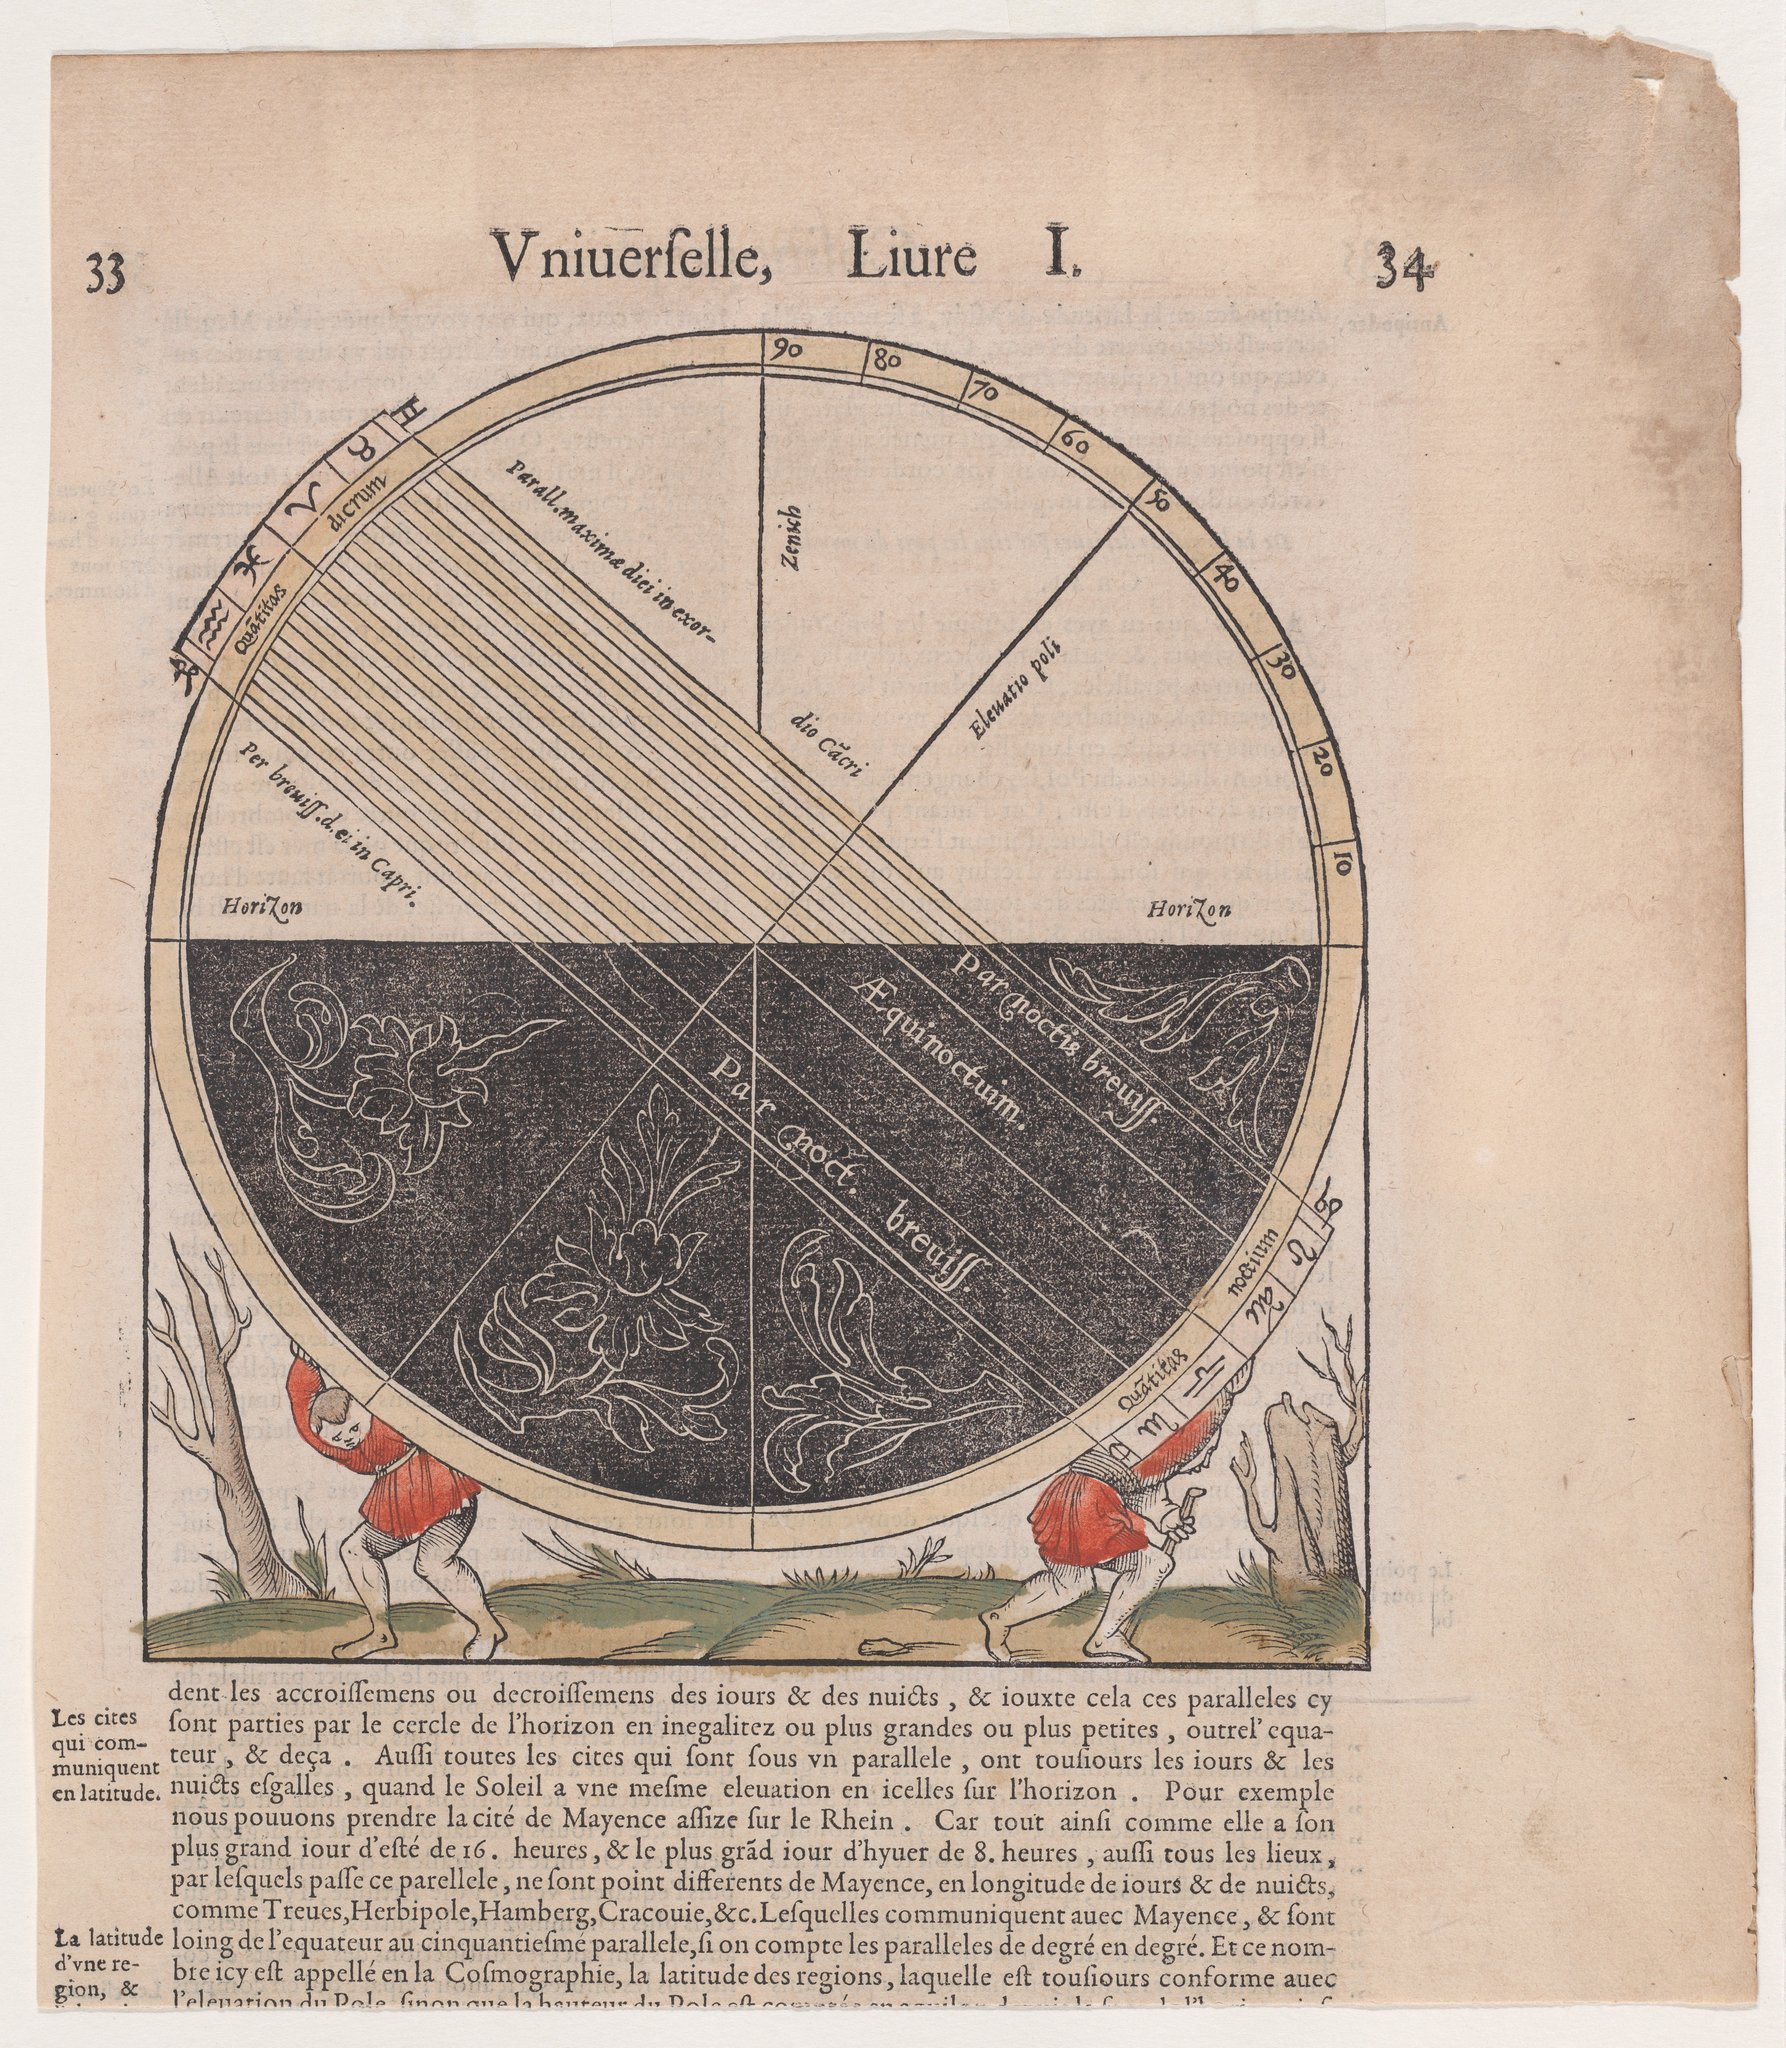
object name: print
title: Page from the Münster Chronick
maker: anonymous, german, 16th century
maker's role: artist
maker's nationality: german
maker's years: 1500-1600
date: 1544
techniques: hand coloring, letterpress, woodcut